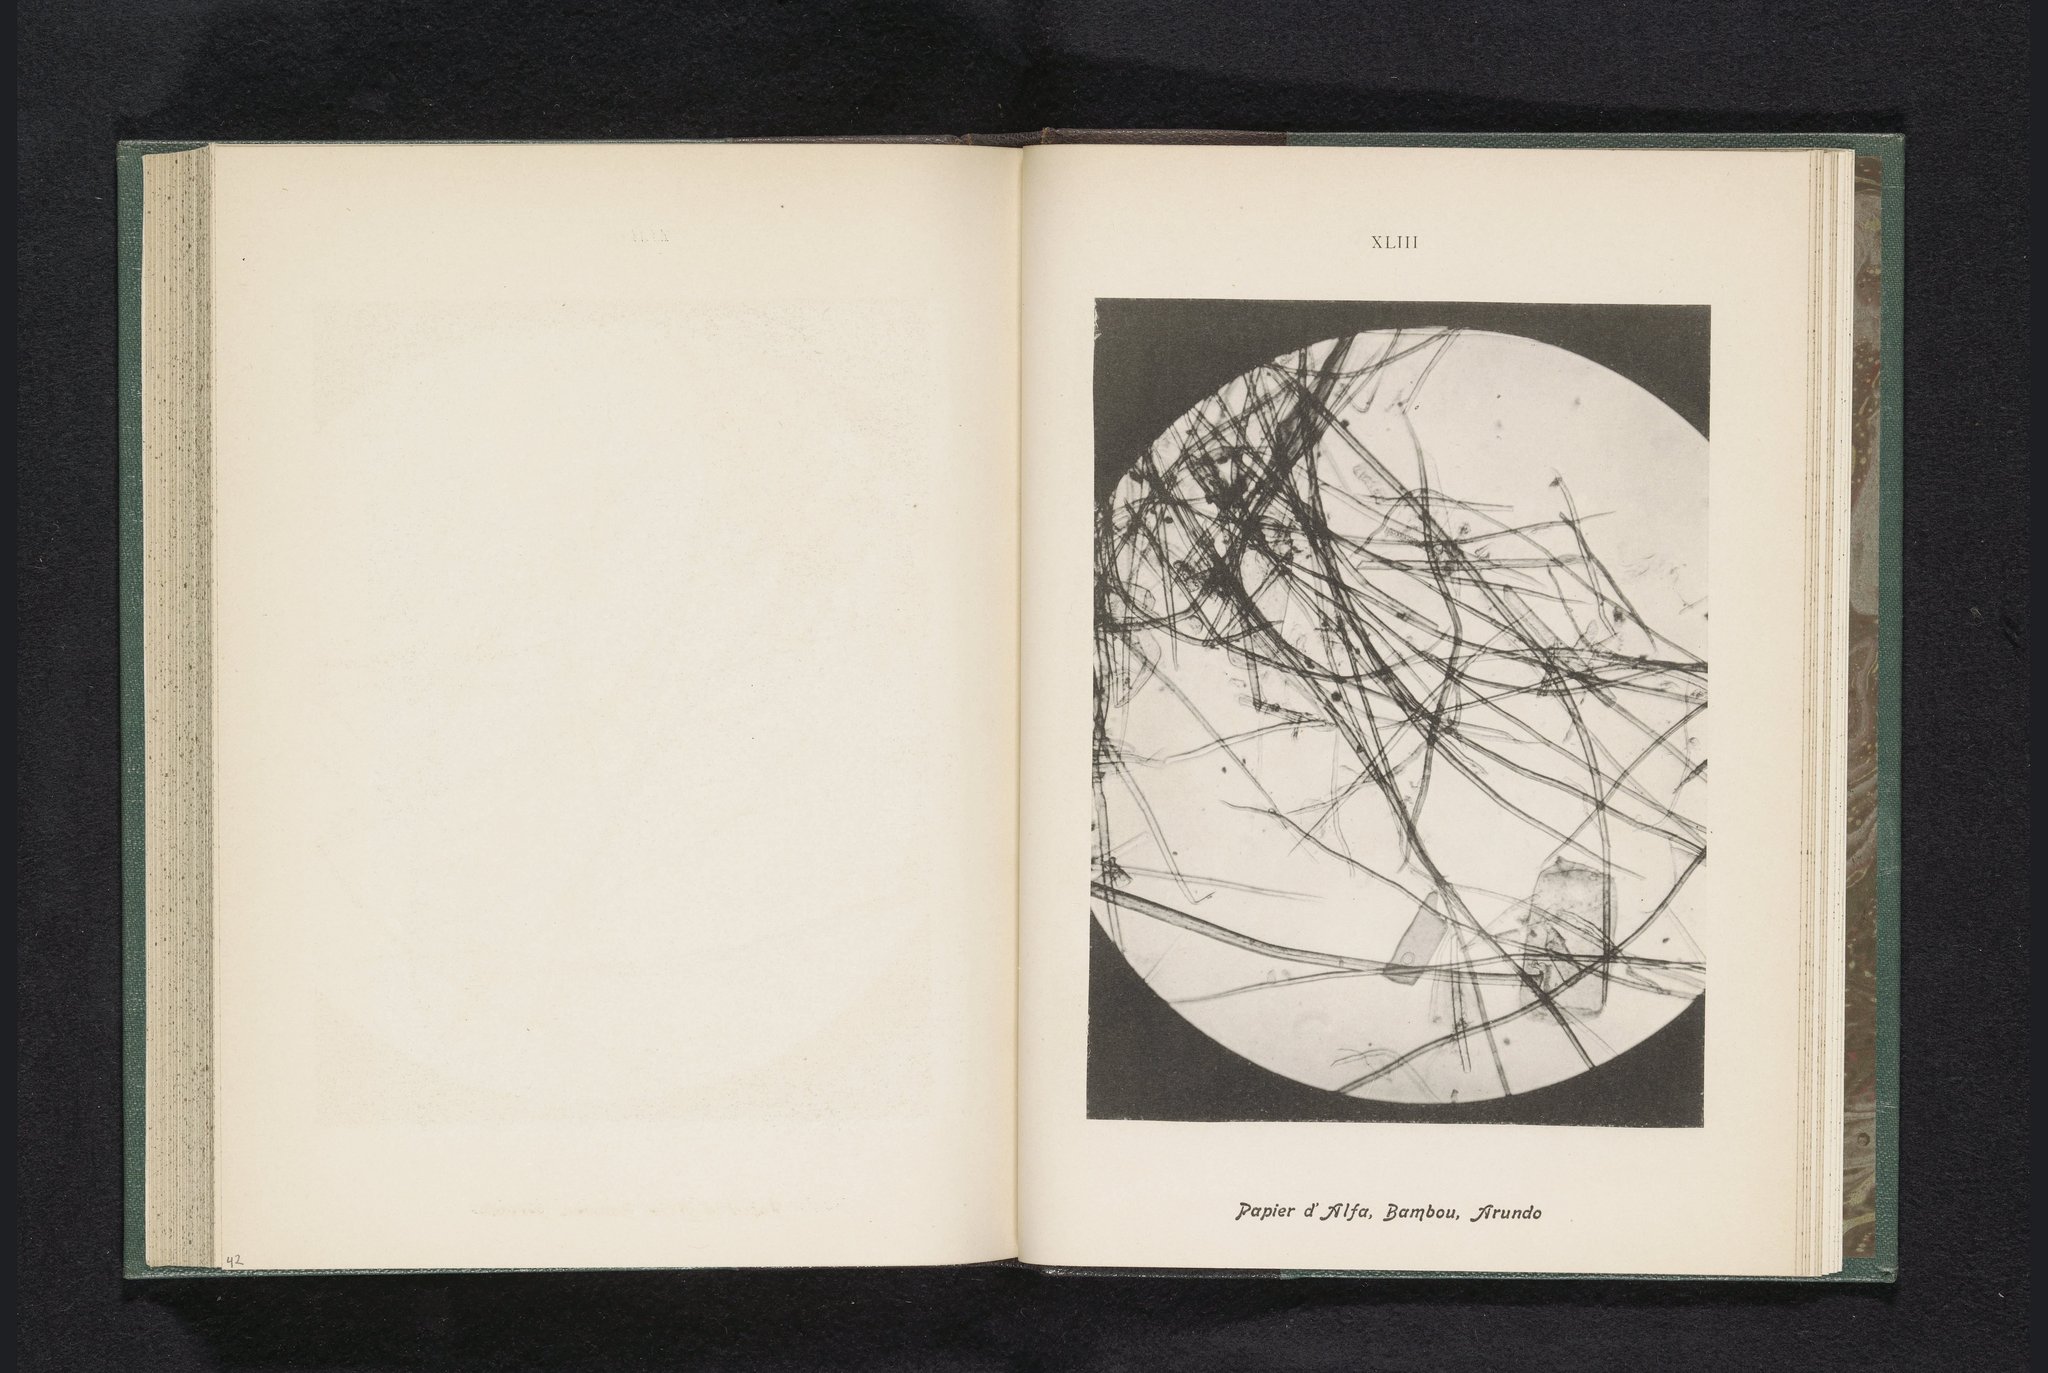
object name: page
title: Papier d'alfa, bambou, arundo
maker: Anonymous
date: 1890-1900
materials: paper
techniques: photograph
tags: plants and herbs: reed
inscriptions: number: ‘XLIII’